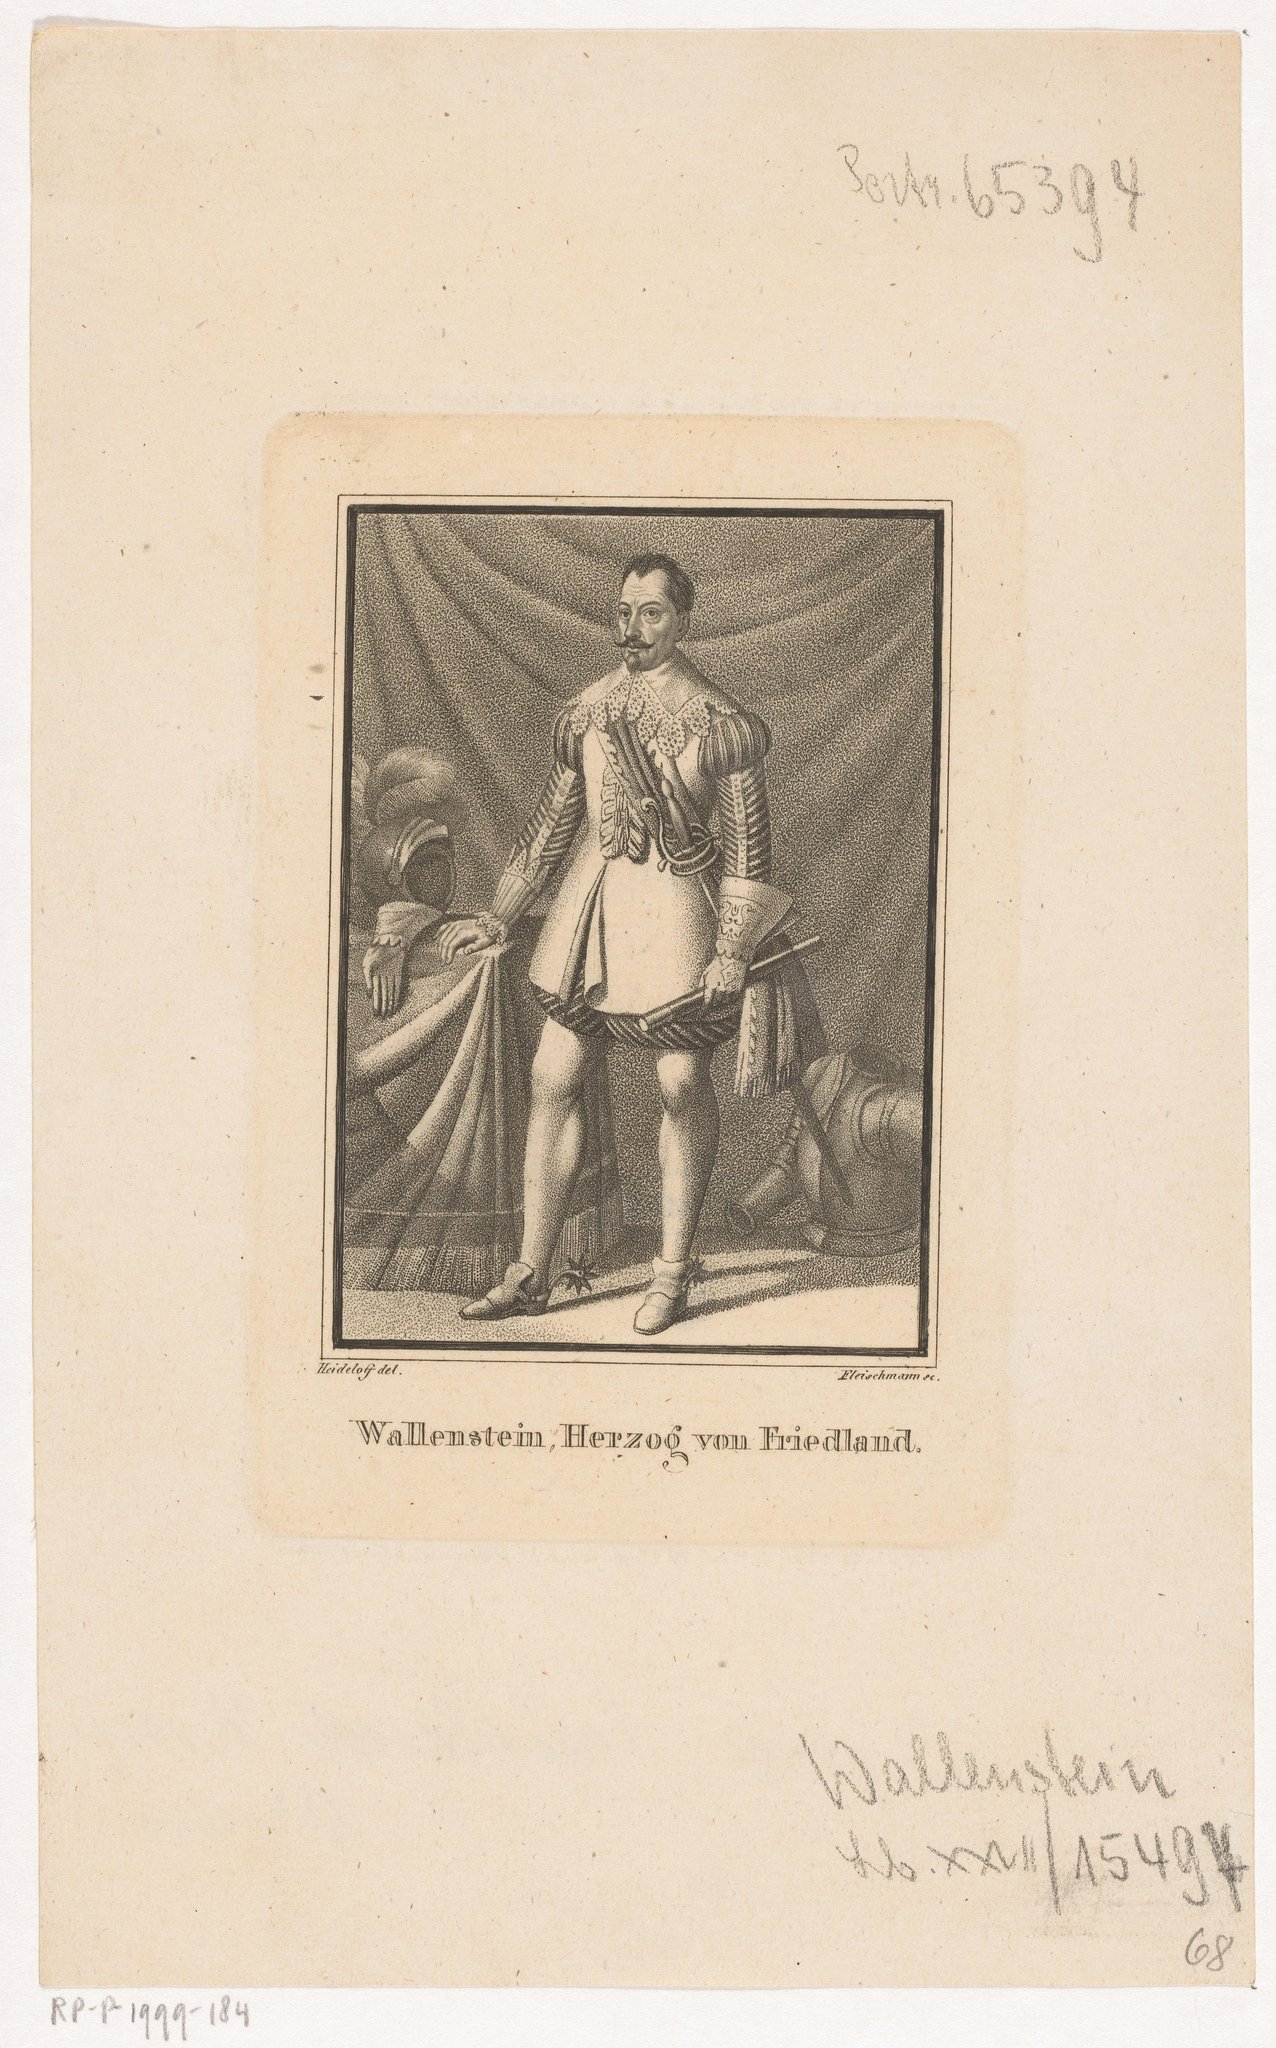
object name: print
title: Portret van Albrecht von Wallenstein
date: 1821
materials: paper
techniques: stippling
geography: nuremberg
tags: helmet, commander-in-chief, general, marshal, armour, historical persons, baton of general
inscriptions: collector's mark: Lugt 2760, collector's mark: Lugt 2228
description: Prent gebruikt voor: Jerrer, Georg Ludwig. Geschichte der Teutschen für die Jugend (...). Neurenberg: Friedrich Campe, 1821.